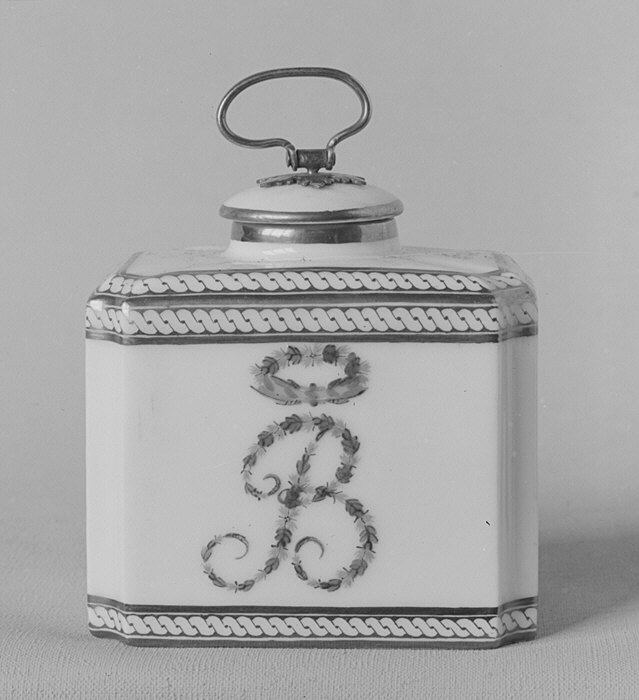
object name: tea caddy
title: Tea caddy (part of a traveling tea service)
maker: dihl et guérhard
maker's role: factory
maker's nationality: french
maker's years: 1781-1824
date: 1788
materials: hard paste porcelain